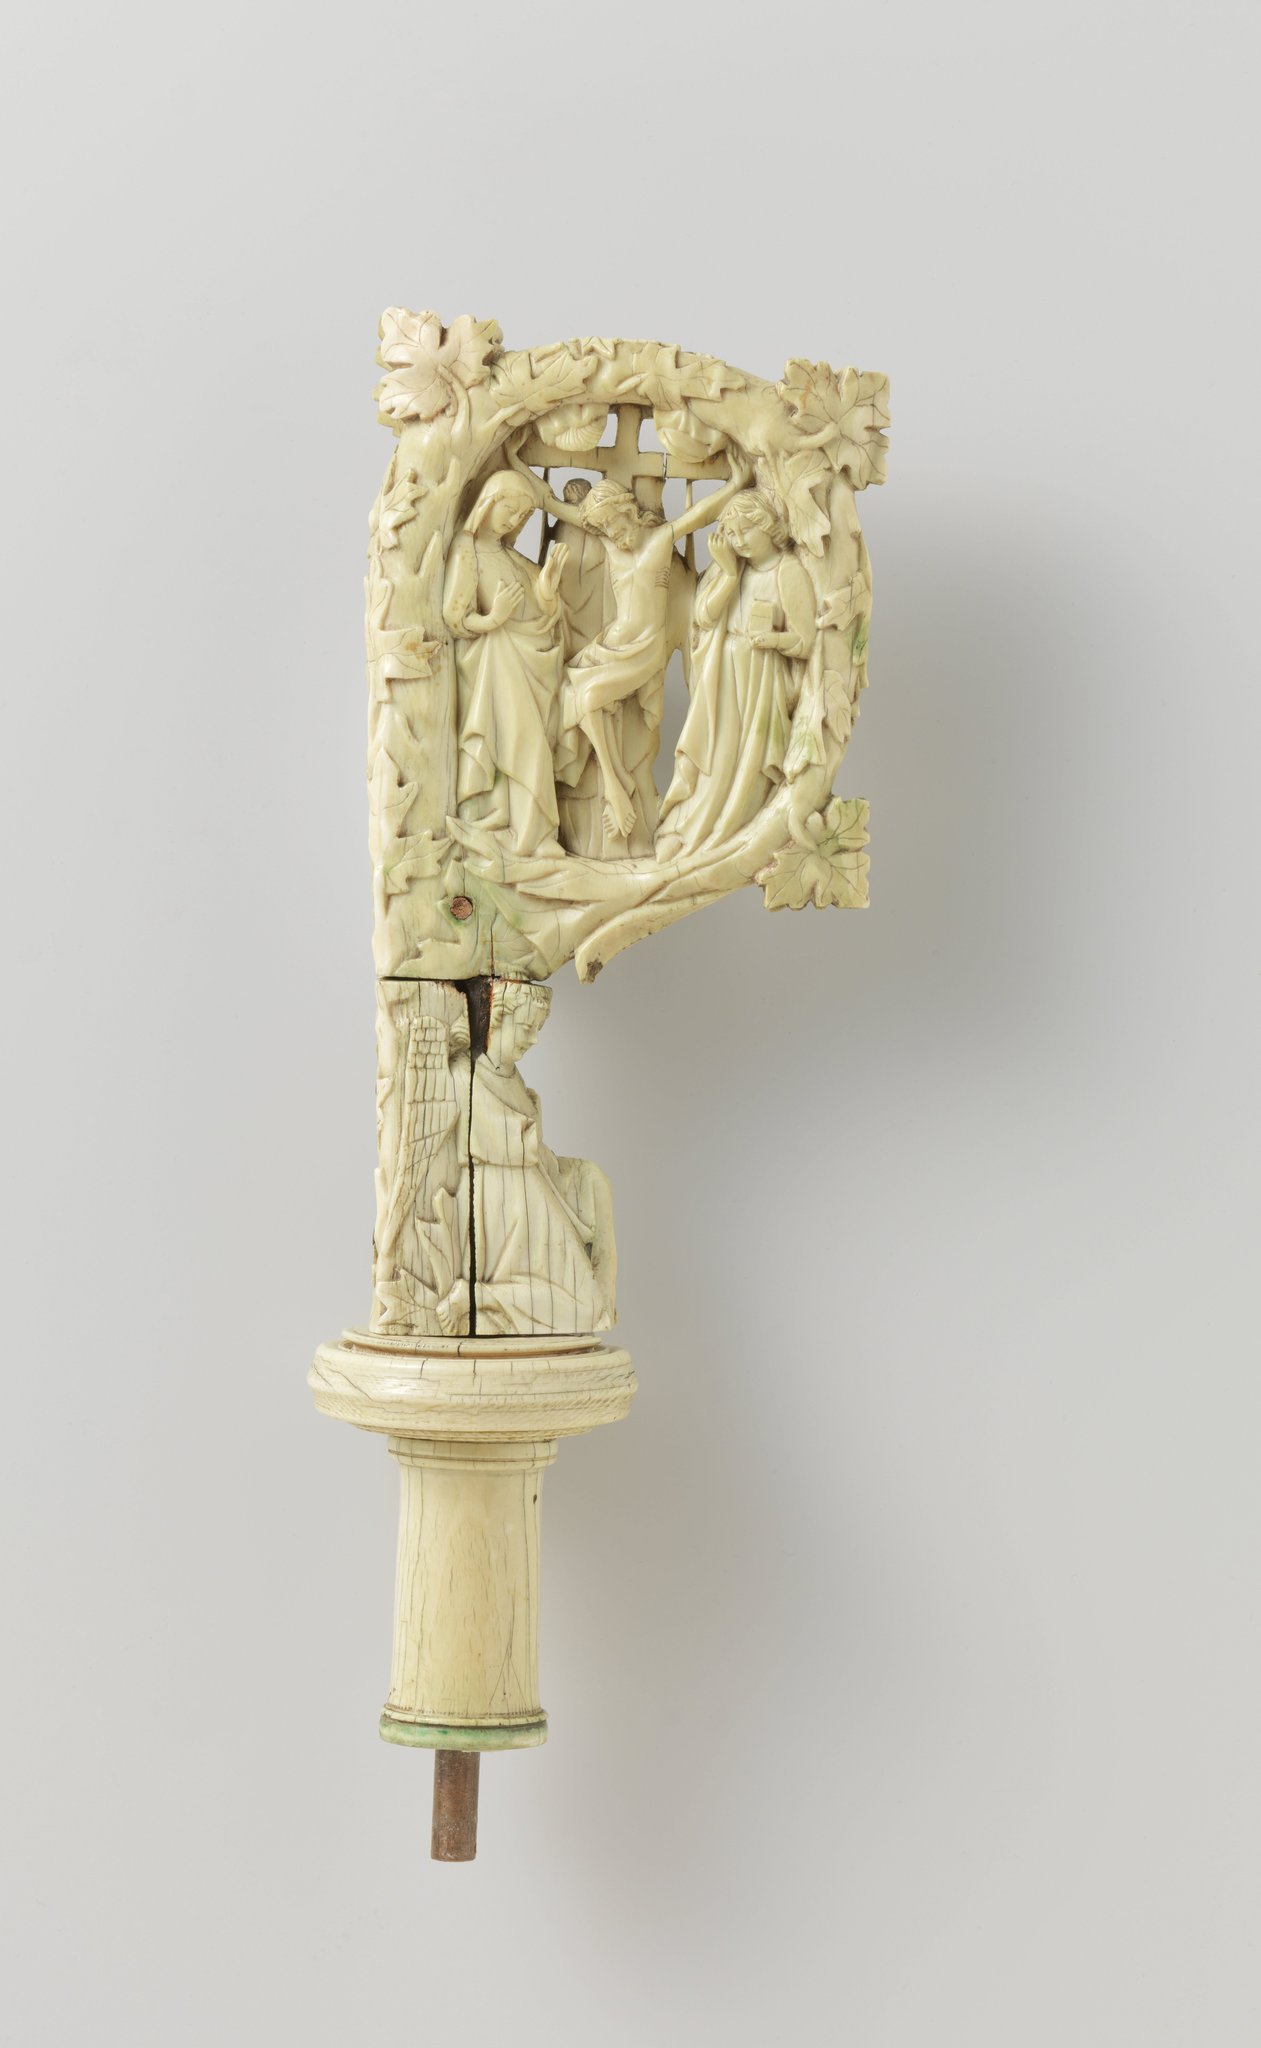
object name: stafbekroning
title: Crozier head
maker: Anonymous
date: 1350-1400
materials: ivory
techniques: cutting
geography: paris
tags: mary standing (or half-length), the christ-child on her arm (christ-child to mary's left), crucified christ with mary and john on either side of the cross; holy rood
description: Op het schijfvormige bovendeel van de staf ontspruit een bebladerde twijg van een wijnstok, die in een krul ombuigt. Deze loopt uit in een langwerpig bladmotief, dat weer aan de twijg aansluit boven het hoofd van een knielende engel, die met de rug en vleugels tegen het onderste deel daarvan is geplaatst. In de krul Maria met kind tussen twee toortshoudende engelen rug aan rug staande met Christus aan het kruis tussen Maria en Johannes. Christus en Maria zijn elkaar toegewend; zij heeft haar linkerhand gebarend opgeheven en houdt de rechter voor de borst. Johannes draagt een boek en droogt zijn tranen met de rechterhand. Boven het kruis zon en maan half bedekt door wolken. Op de keerzijde heeft Maria in de rechterhand een vogel en op de linkerarm het kind, dat met een hand naar de vogel reikt en in de ander een appel houdt.